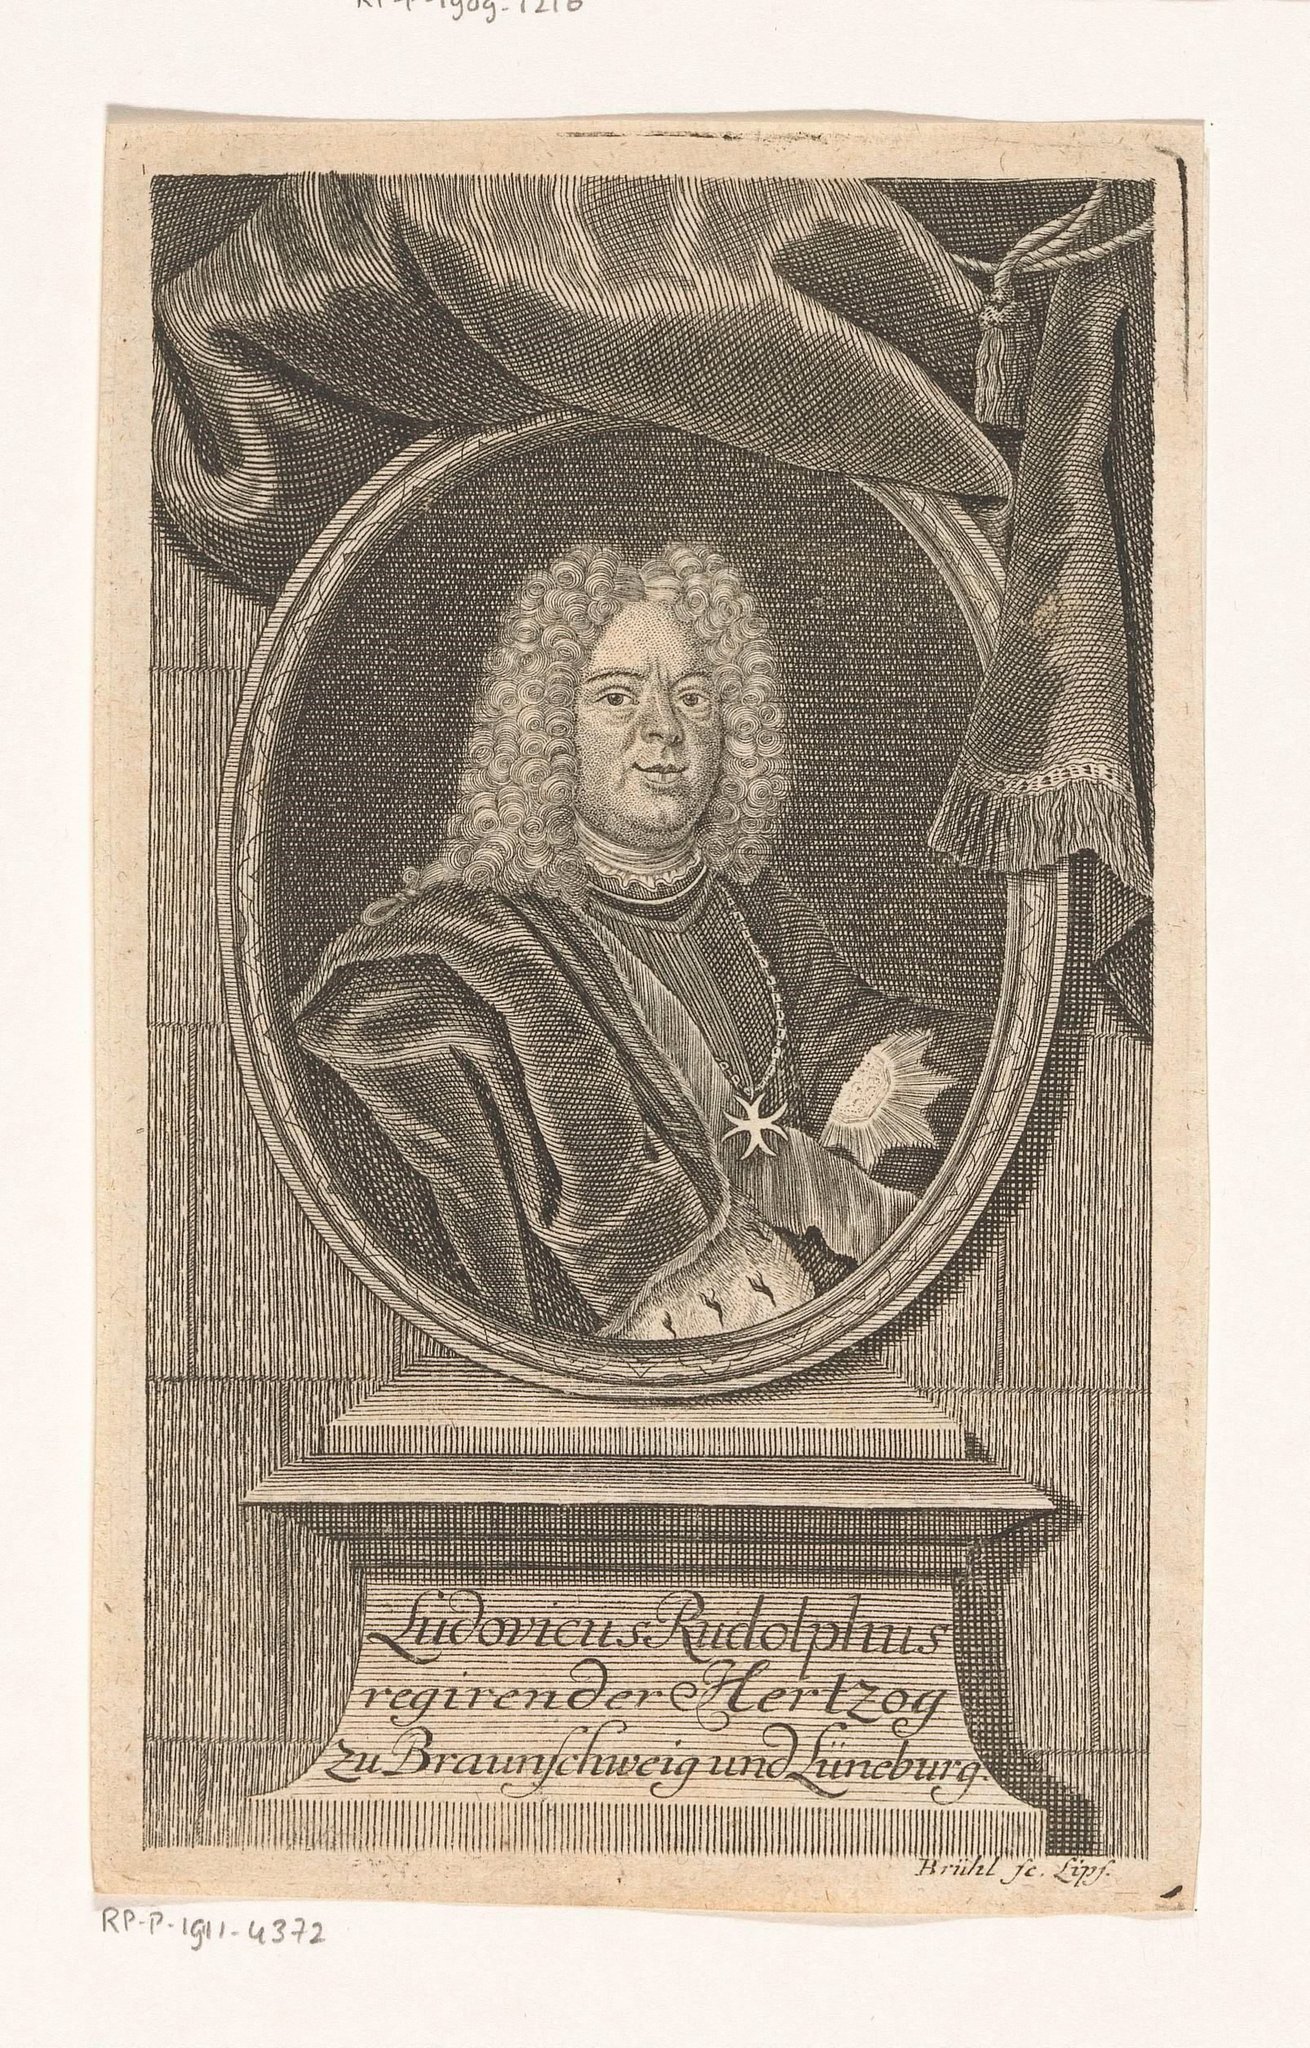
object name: print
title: Portret van Ludwig Rudolf von Braunschweig-Wolfenbüttel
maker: johann benjamin brühl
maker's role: print maker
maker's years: 1691-1763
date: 1732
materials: paper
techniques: engraving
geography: leipzig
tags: knighthood order, historical persons, mantle, gown, dress (symbol of sovereignty)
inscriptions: collector's mark: Lugt 2228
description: Prent ook gebruikt in: Benthem, Henrich Ludolph. Neu-eröffneter Engeländischer Kirch- und Schulen-Staat (...). Leipzig: Philipp Gottfried Saurmann, 1732.